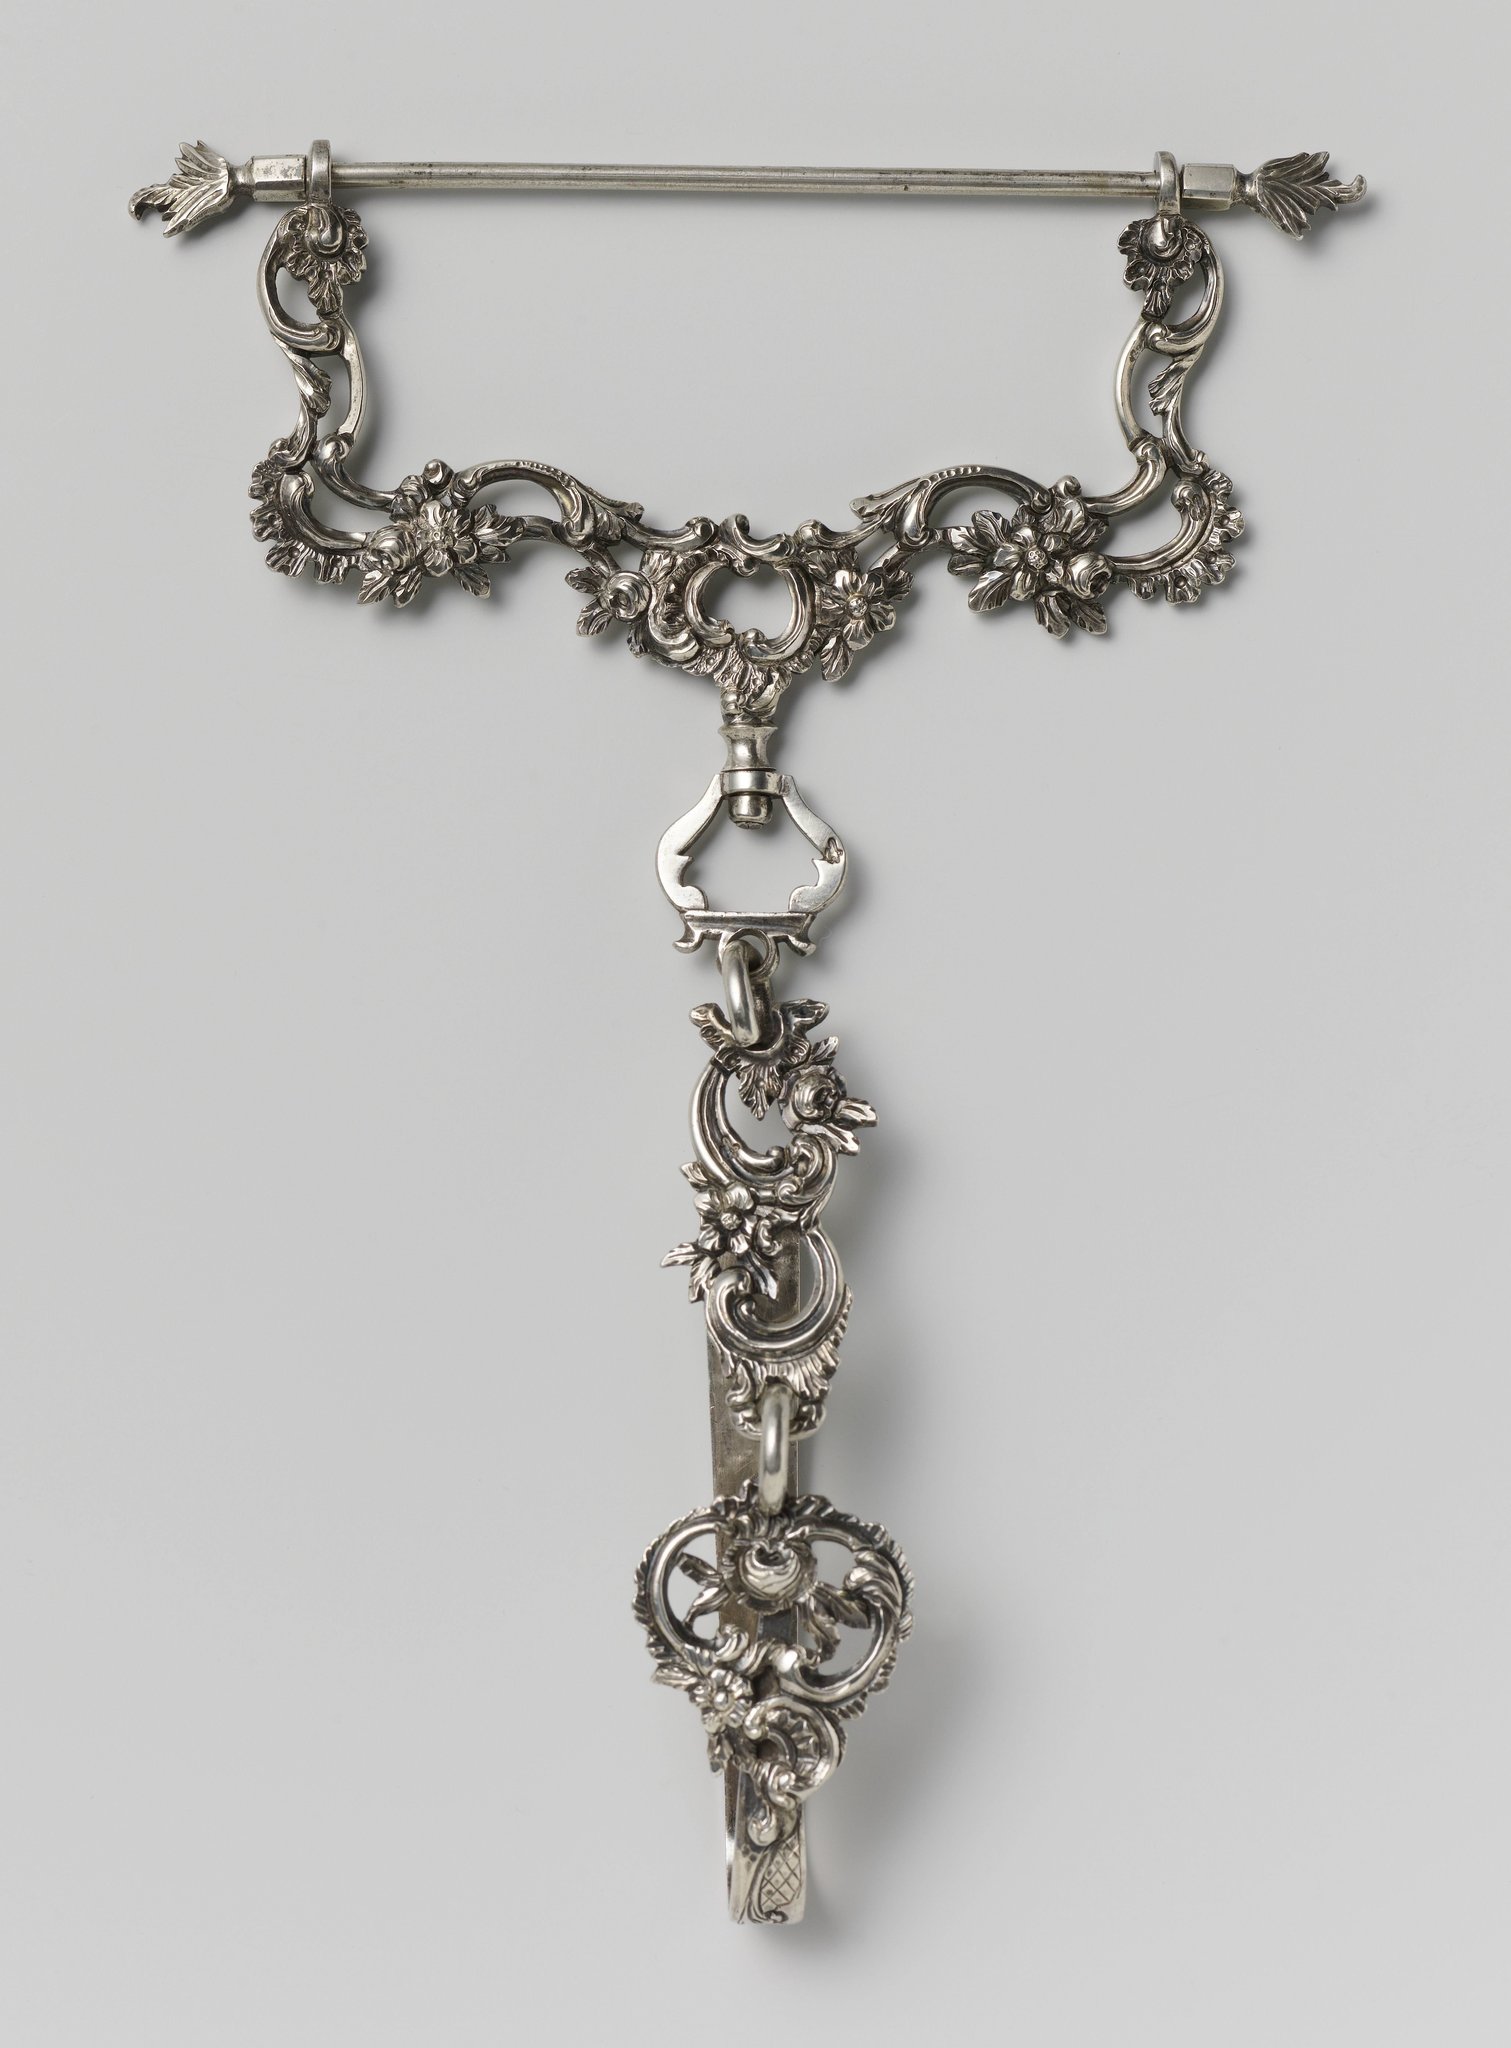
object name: textile working equipment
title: Kluwenhouder, opgebouwd uit C-voluten versierd met bladeren, schuim- en rocaillemotieven en bloemen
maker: dirk froger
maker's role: silversmith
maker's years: 1708-1780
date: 1775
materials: silver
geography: amsterdam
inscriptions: maker's mark, duty mark, date letter: ‘Q’, town mark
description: De kluwenhouder bestaat uit een beugel met aan de onderzijde twee oogjes, waarin een pen past die in twee bladvormige asymmetrische vleugels eindigt, waarvan er één afschroefbaar is. Aan de bovenzijde van de beugel is een draaibaar verbindingsstuk bevestigd met daaraan een oogje, waarin het oog van een grote schakel past. De haak is weer met een groot oog aan deze schakel bevestigd. De haak verbreedt zich naar het afgeronde uiteinde en heeft aan de voorzijde een opgelegd sierstuk. De beugel, de schakel en het sierstuk op de haak, alle opengewerkt en asymmetrisch, zijn opgebouwd uit C-voluten versierd met bladeren, schuim- en rocailleranden en bloemen waaronder rozen. Het open verbindingsstuk tussen beugel en schakel bestaat uit twee geschulpte voluten verbonden door een geprofileerde balk. De haak is boven het sierstuk gegraveerd met C-voluten met bladeren en traliewerk.